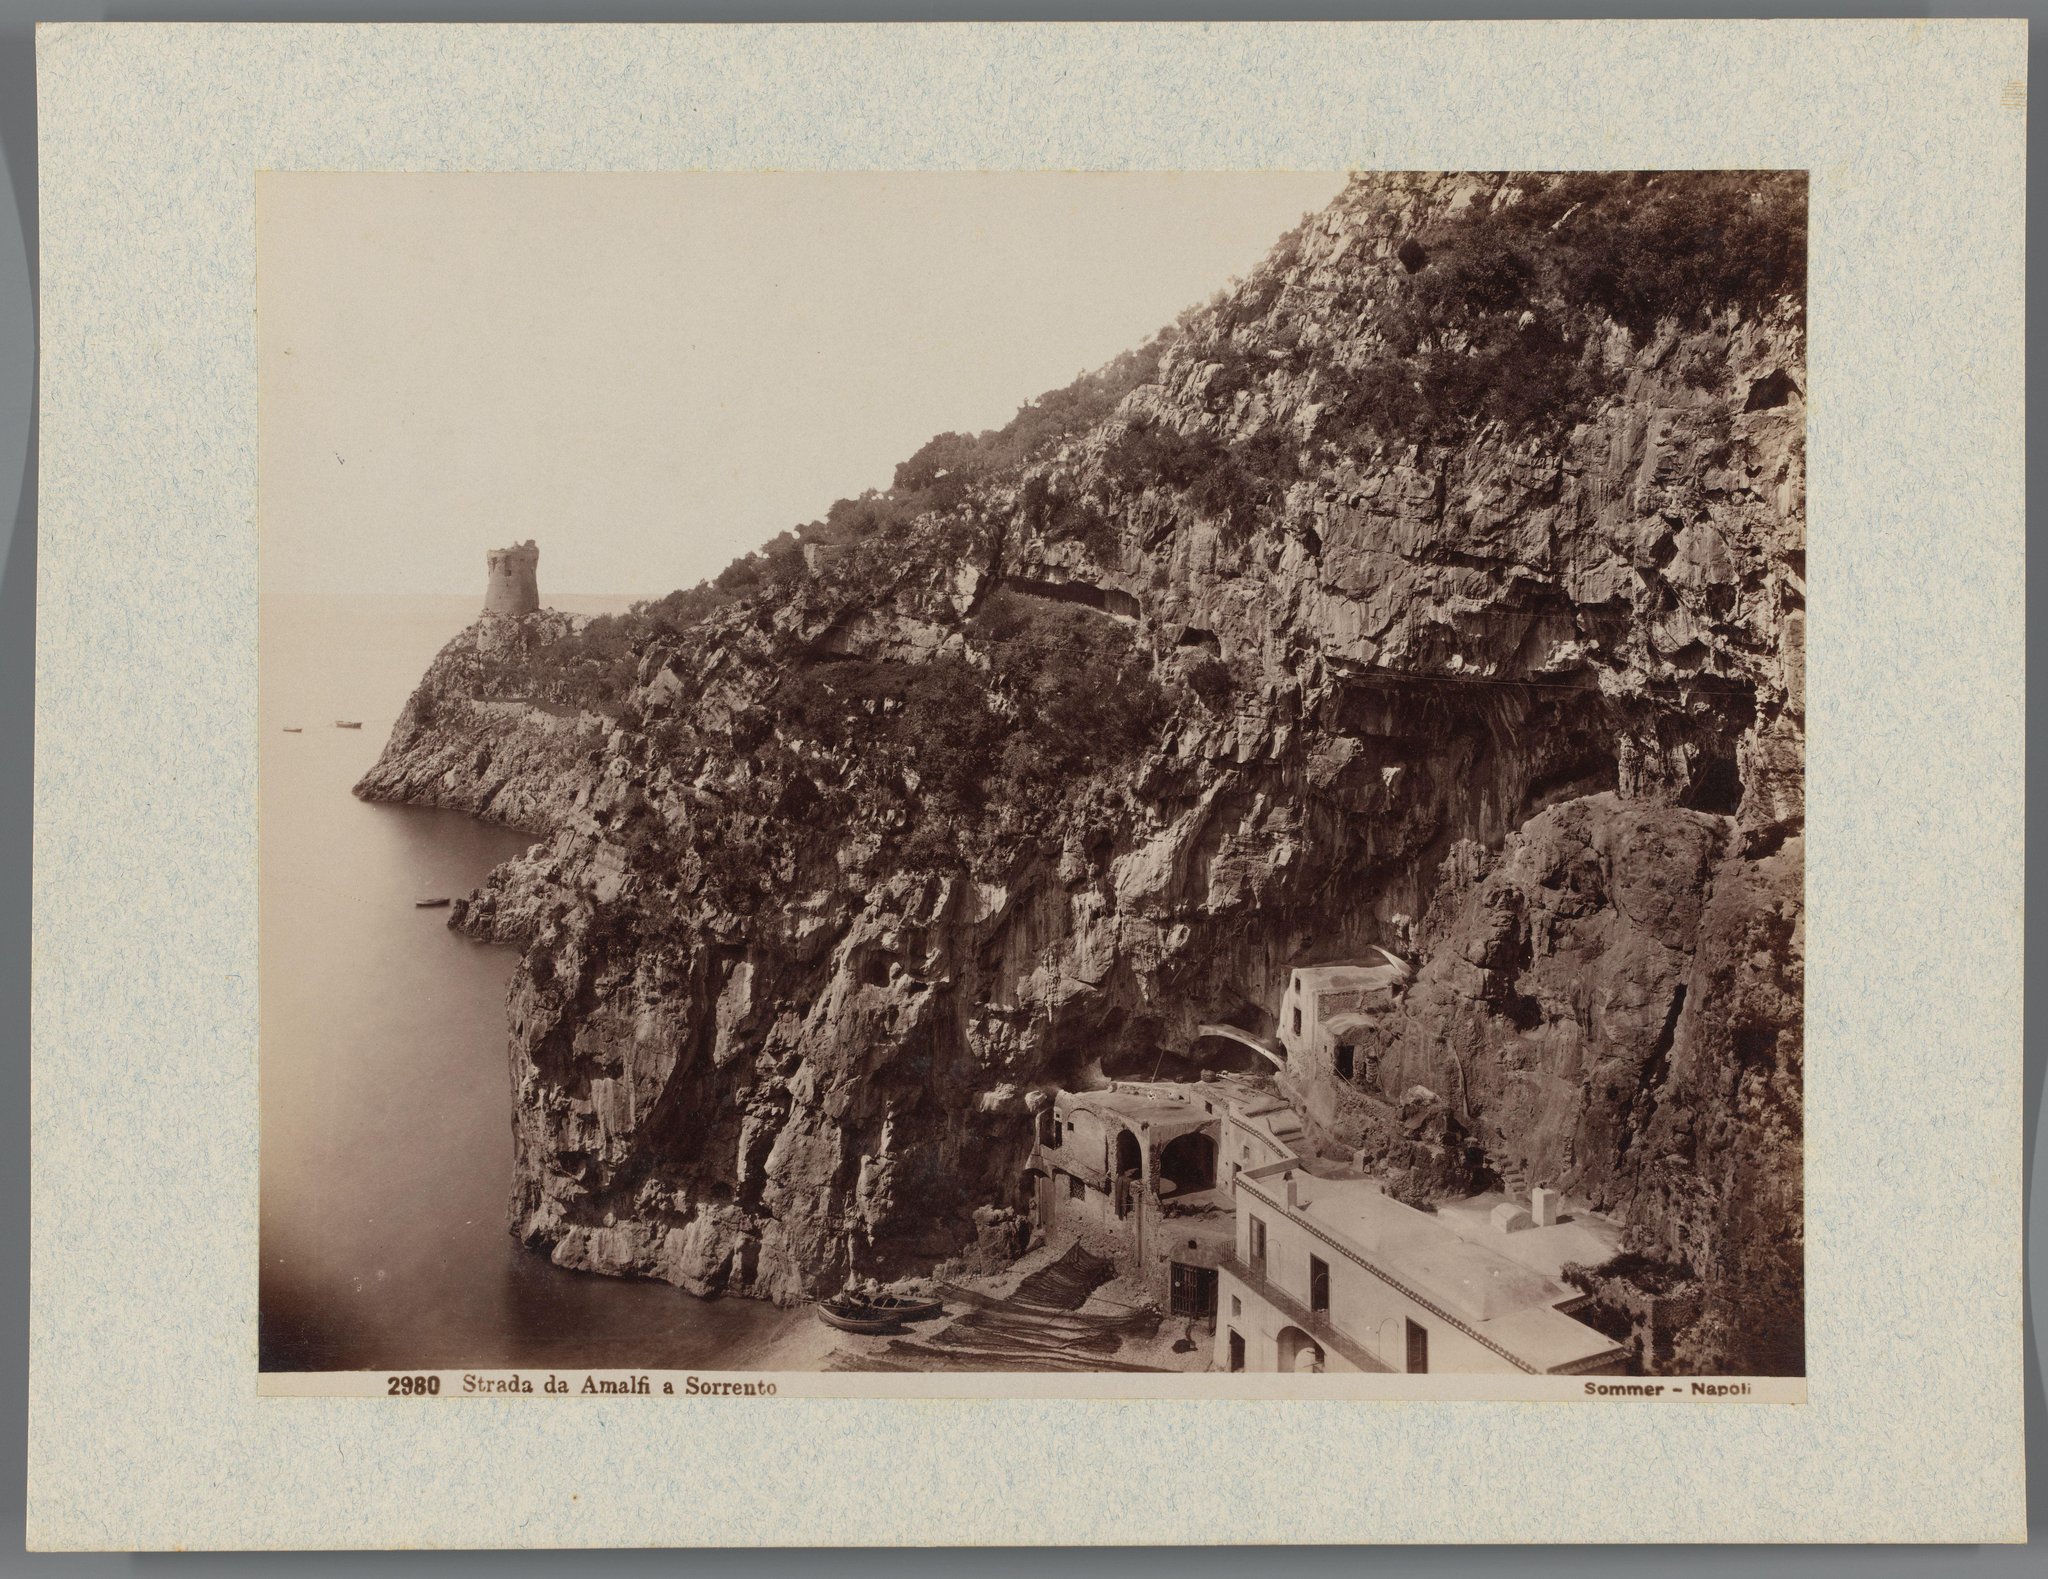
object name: photograph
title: Italië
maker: Anonymous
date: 1880-1910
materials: photographic support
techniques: albumen print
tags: italy